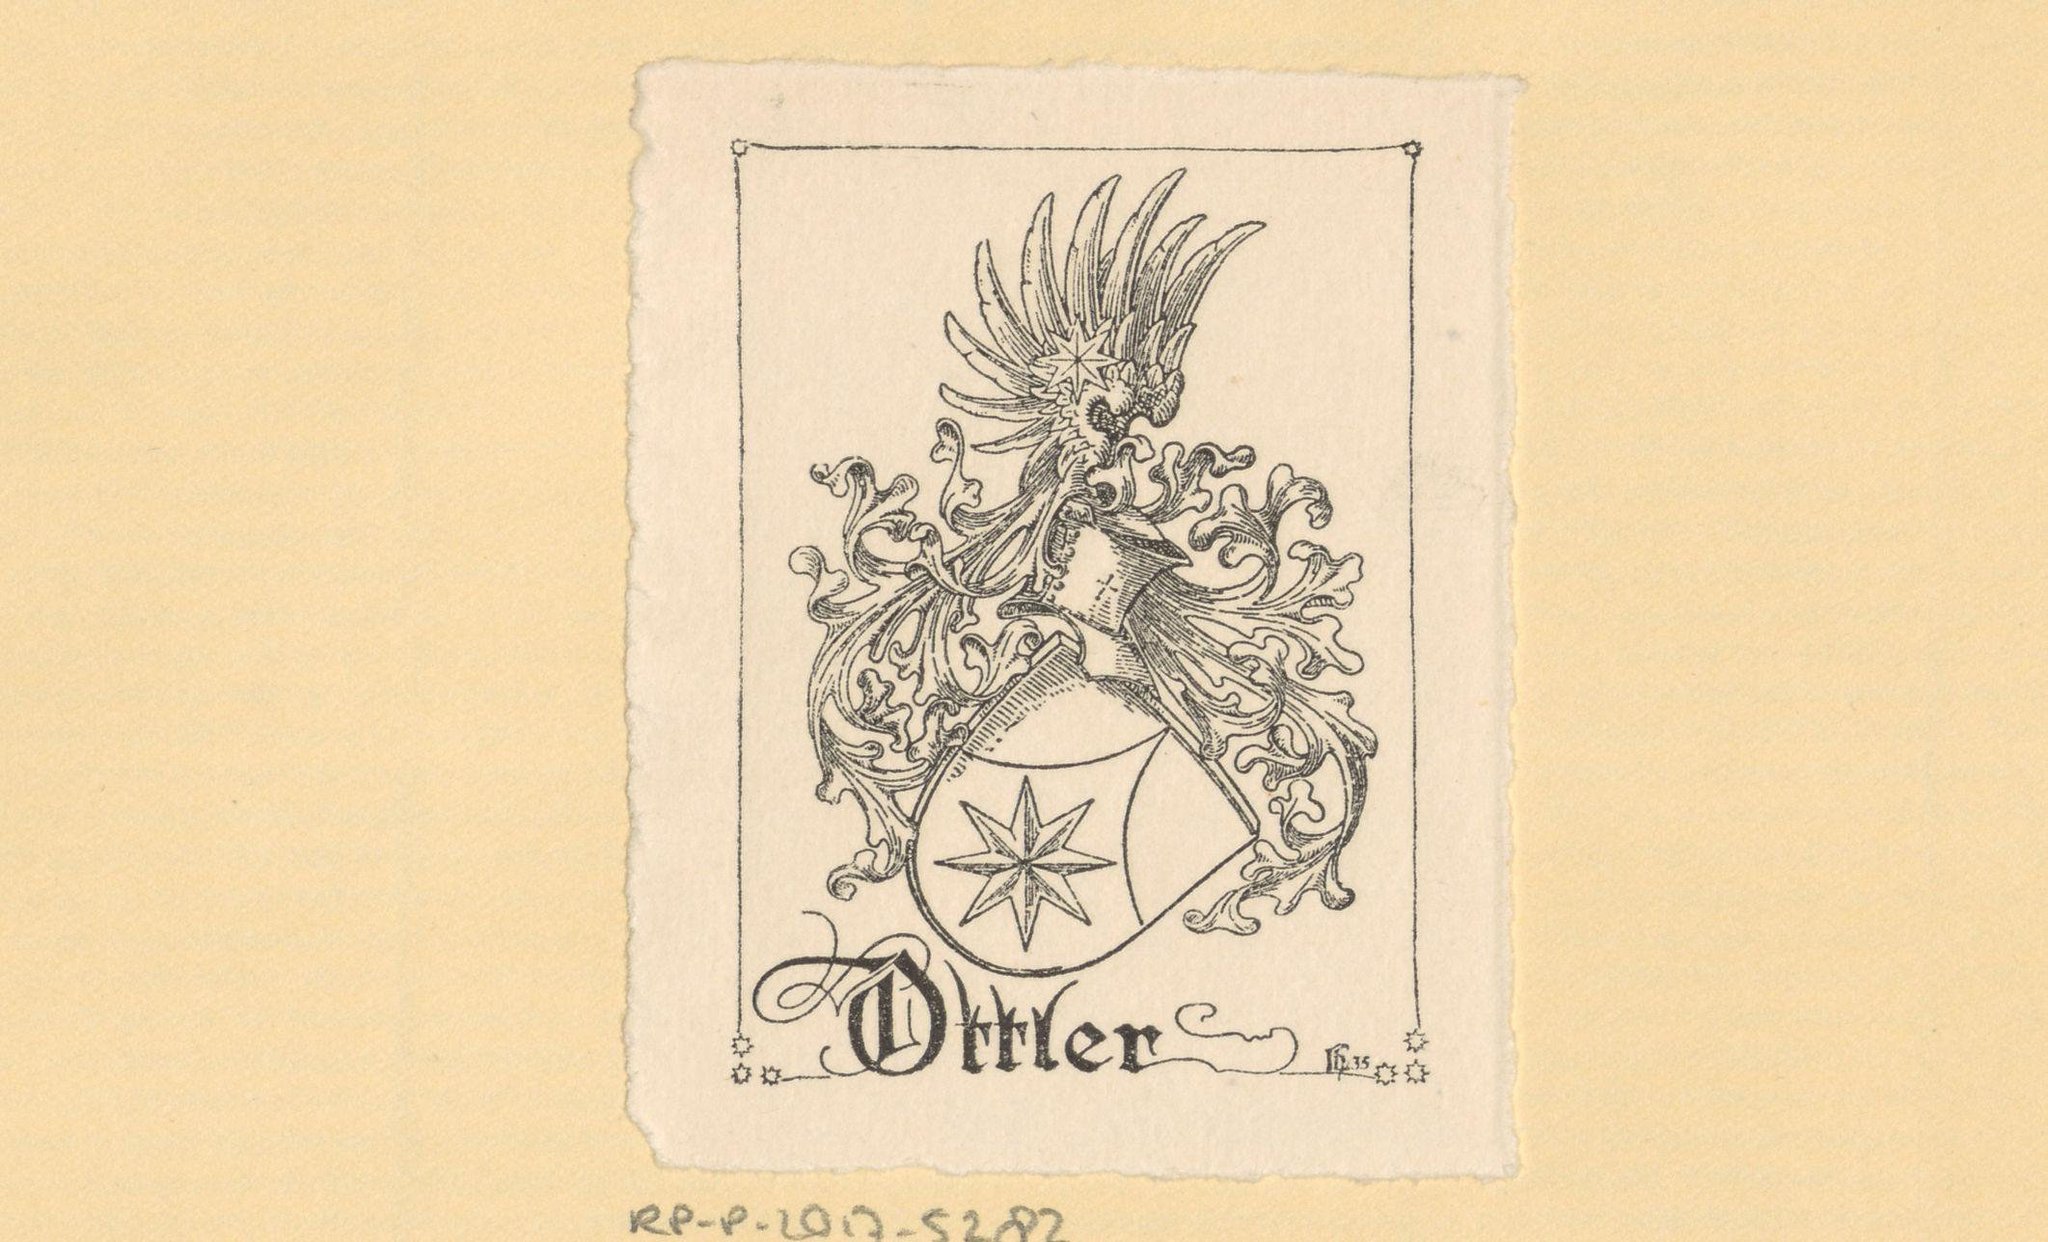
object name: bookplate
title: Ex libris van Ottler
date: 1935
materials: paper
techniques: printing block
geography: germany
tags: stars, armorial bearing, heraldry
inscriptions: date